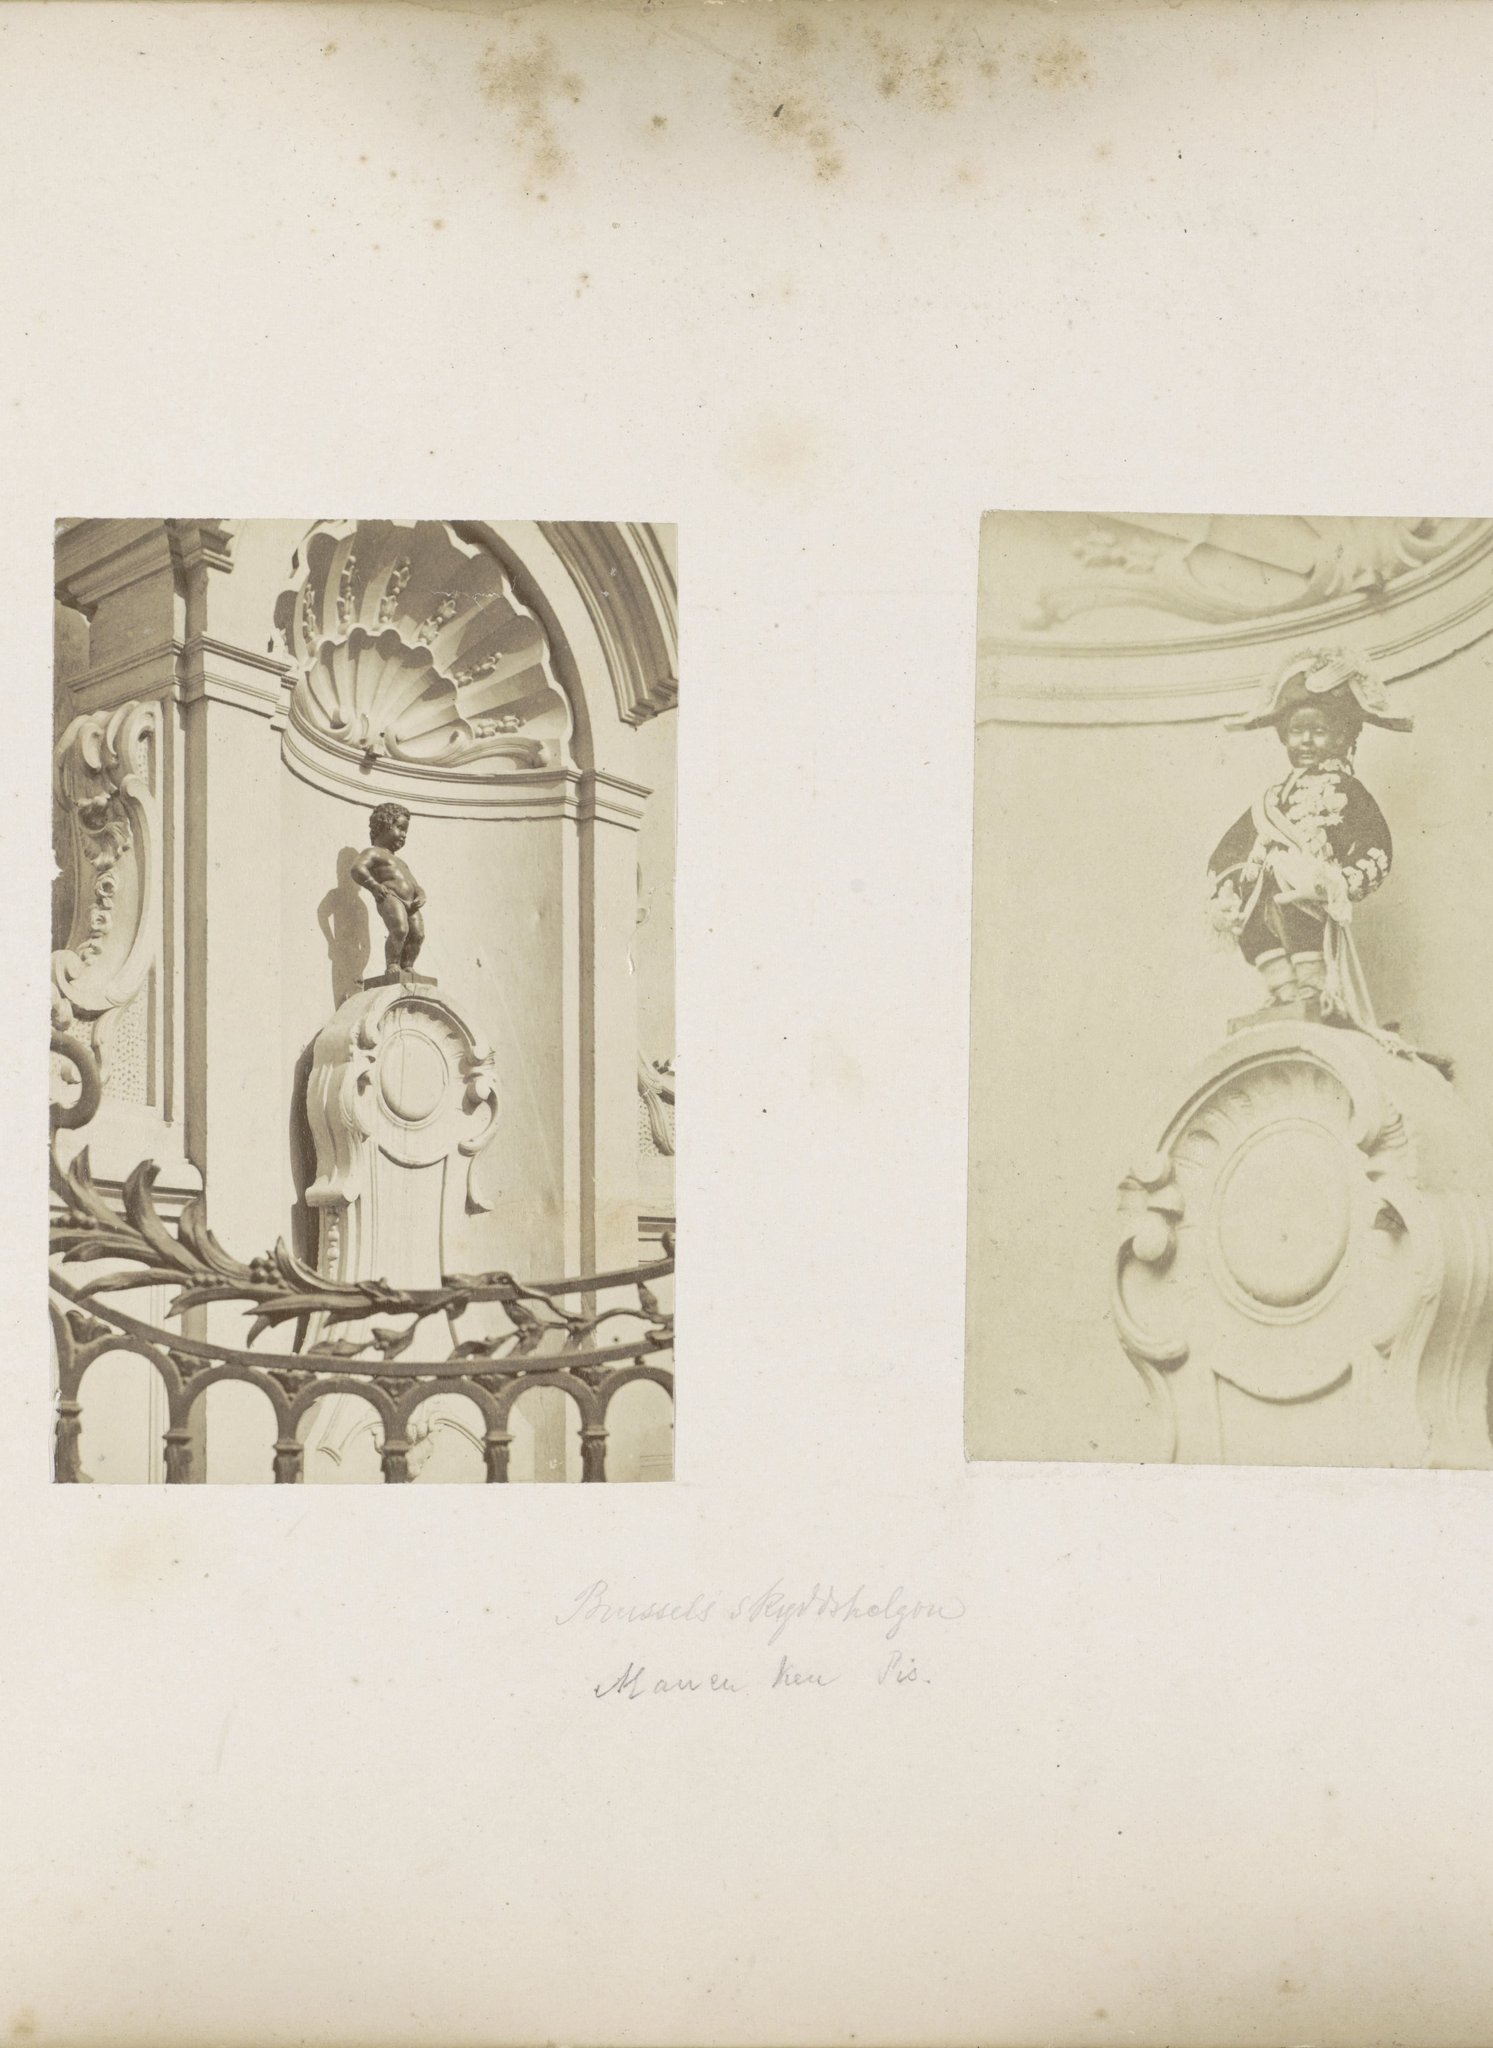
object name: photograph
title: Beeld van Manneken Pis met kostuum, onderscheidingen, sjerp en steek in Brussel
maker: Anonymous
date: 1878-1890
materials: photographic support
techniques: albumen print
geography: brussels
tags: piece of sculpture, reproduction of a piece of sculpture (+ sculpture), attributes of dignitary (+ dressing, putting on clothes), ornamental fountain, brussels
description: Onderdeel van Reisalbum Europese steden, vermoedelijk Zweeds.